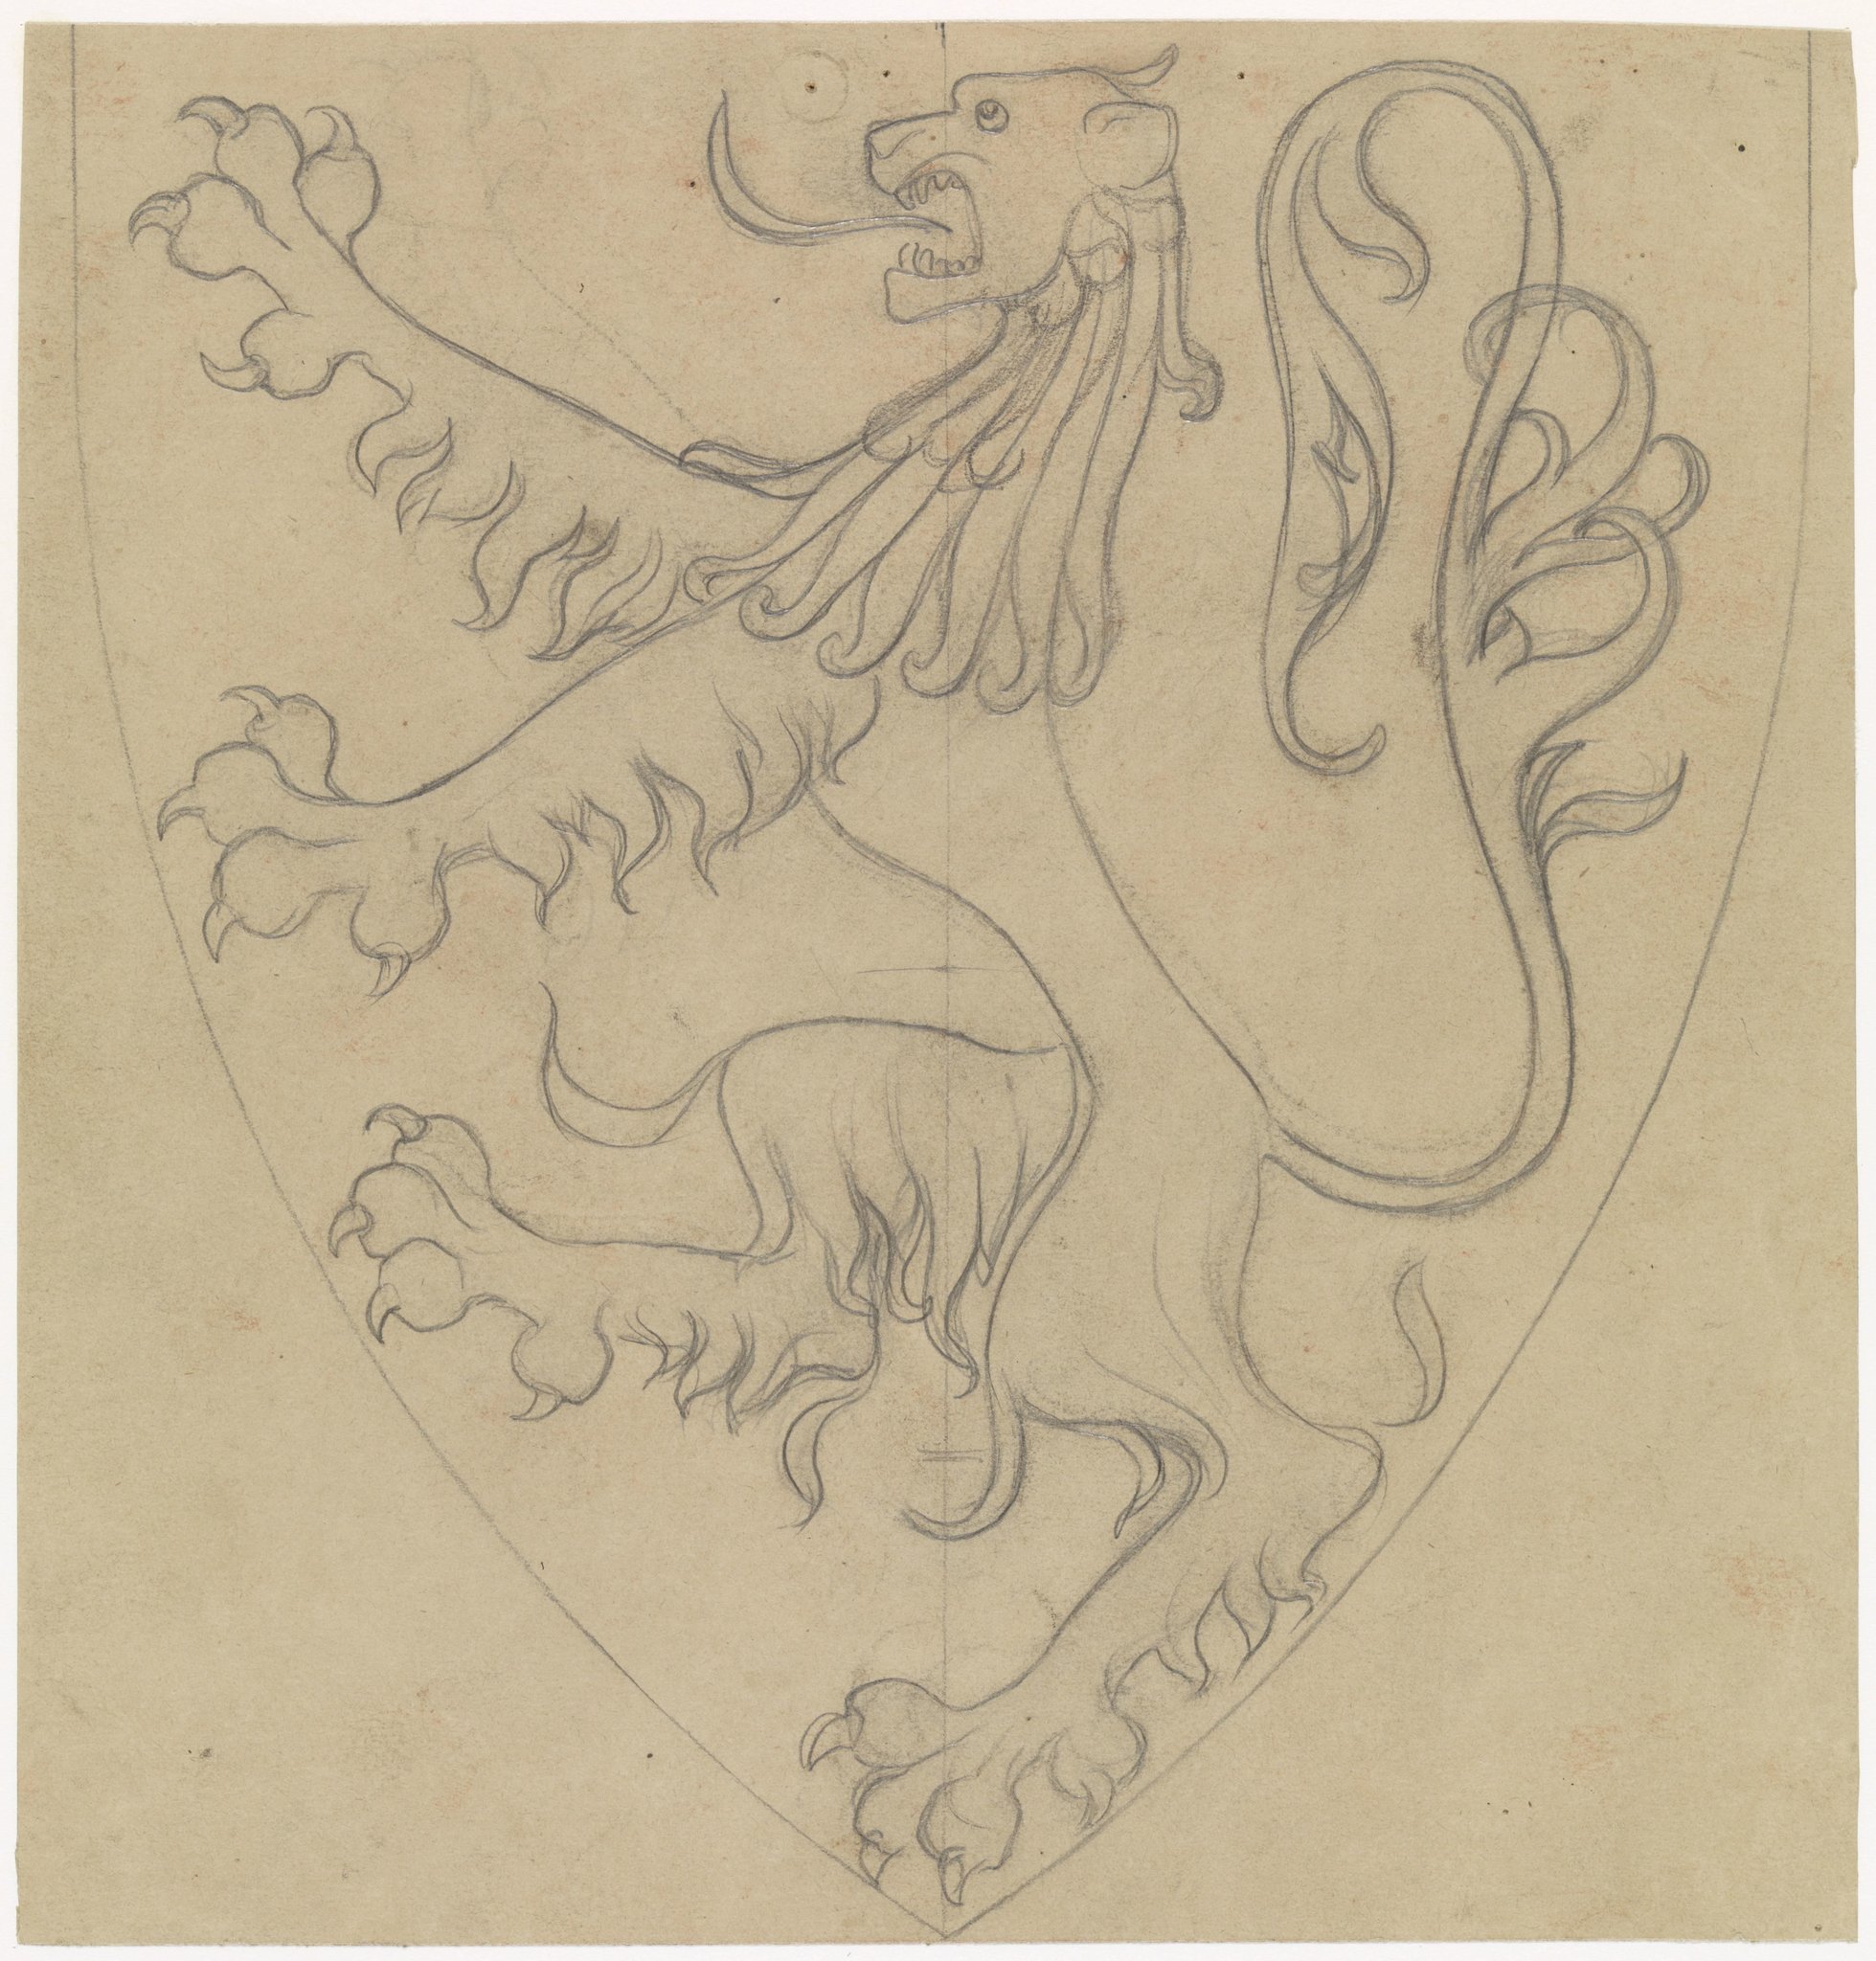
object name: drawing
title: Wapen met klimmende leeuw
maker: antoon derkinderen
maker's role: draughtsman, painter, print maker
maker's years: 1859-1925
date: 1869-1925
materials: chalk, paper, pencil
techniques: pouncing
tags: beasts of prey, predatory animals: lion (+ heraldic animals)